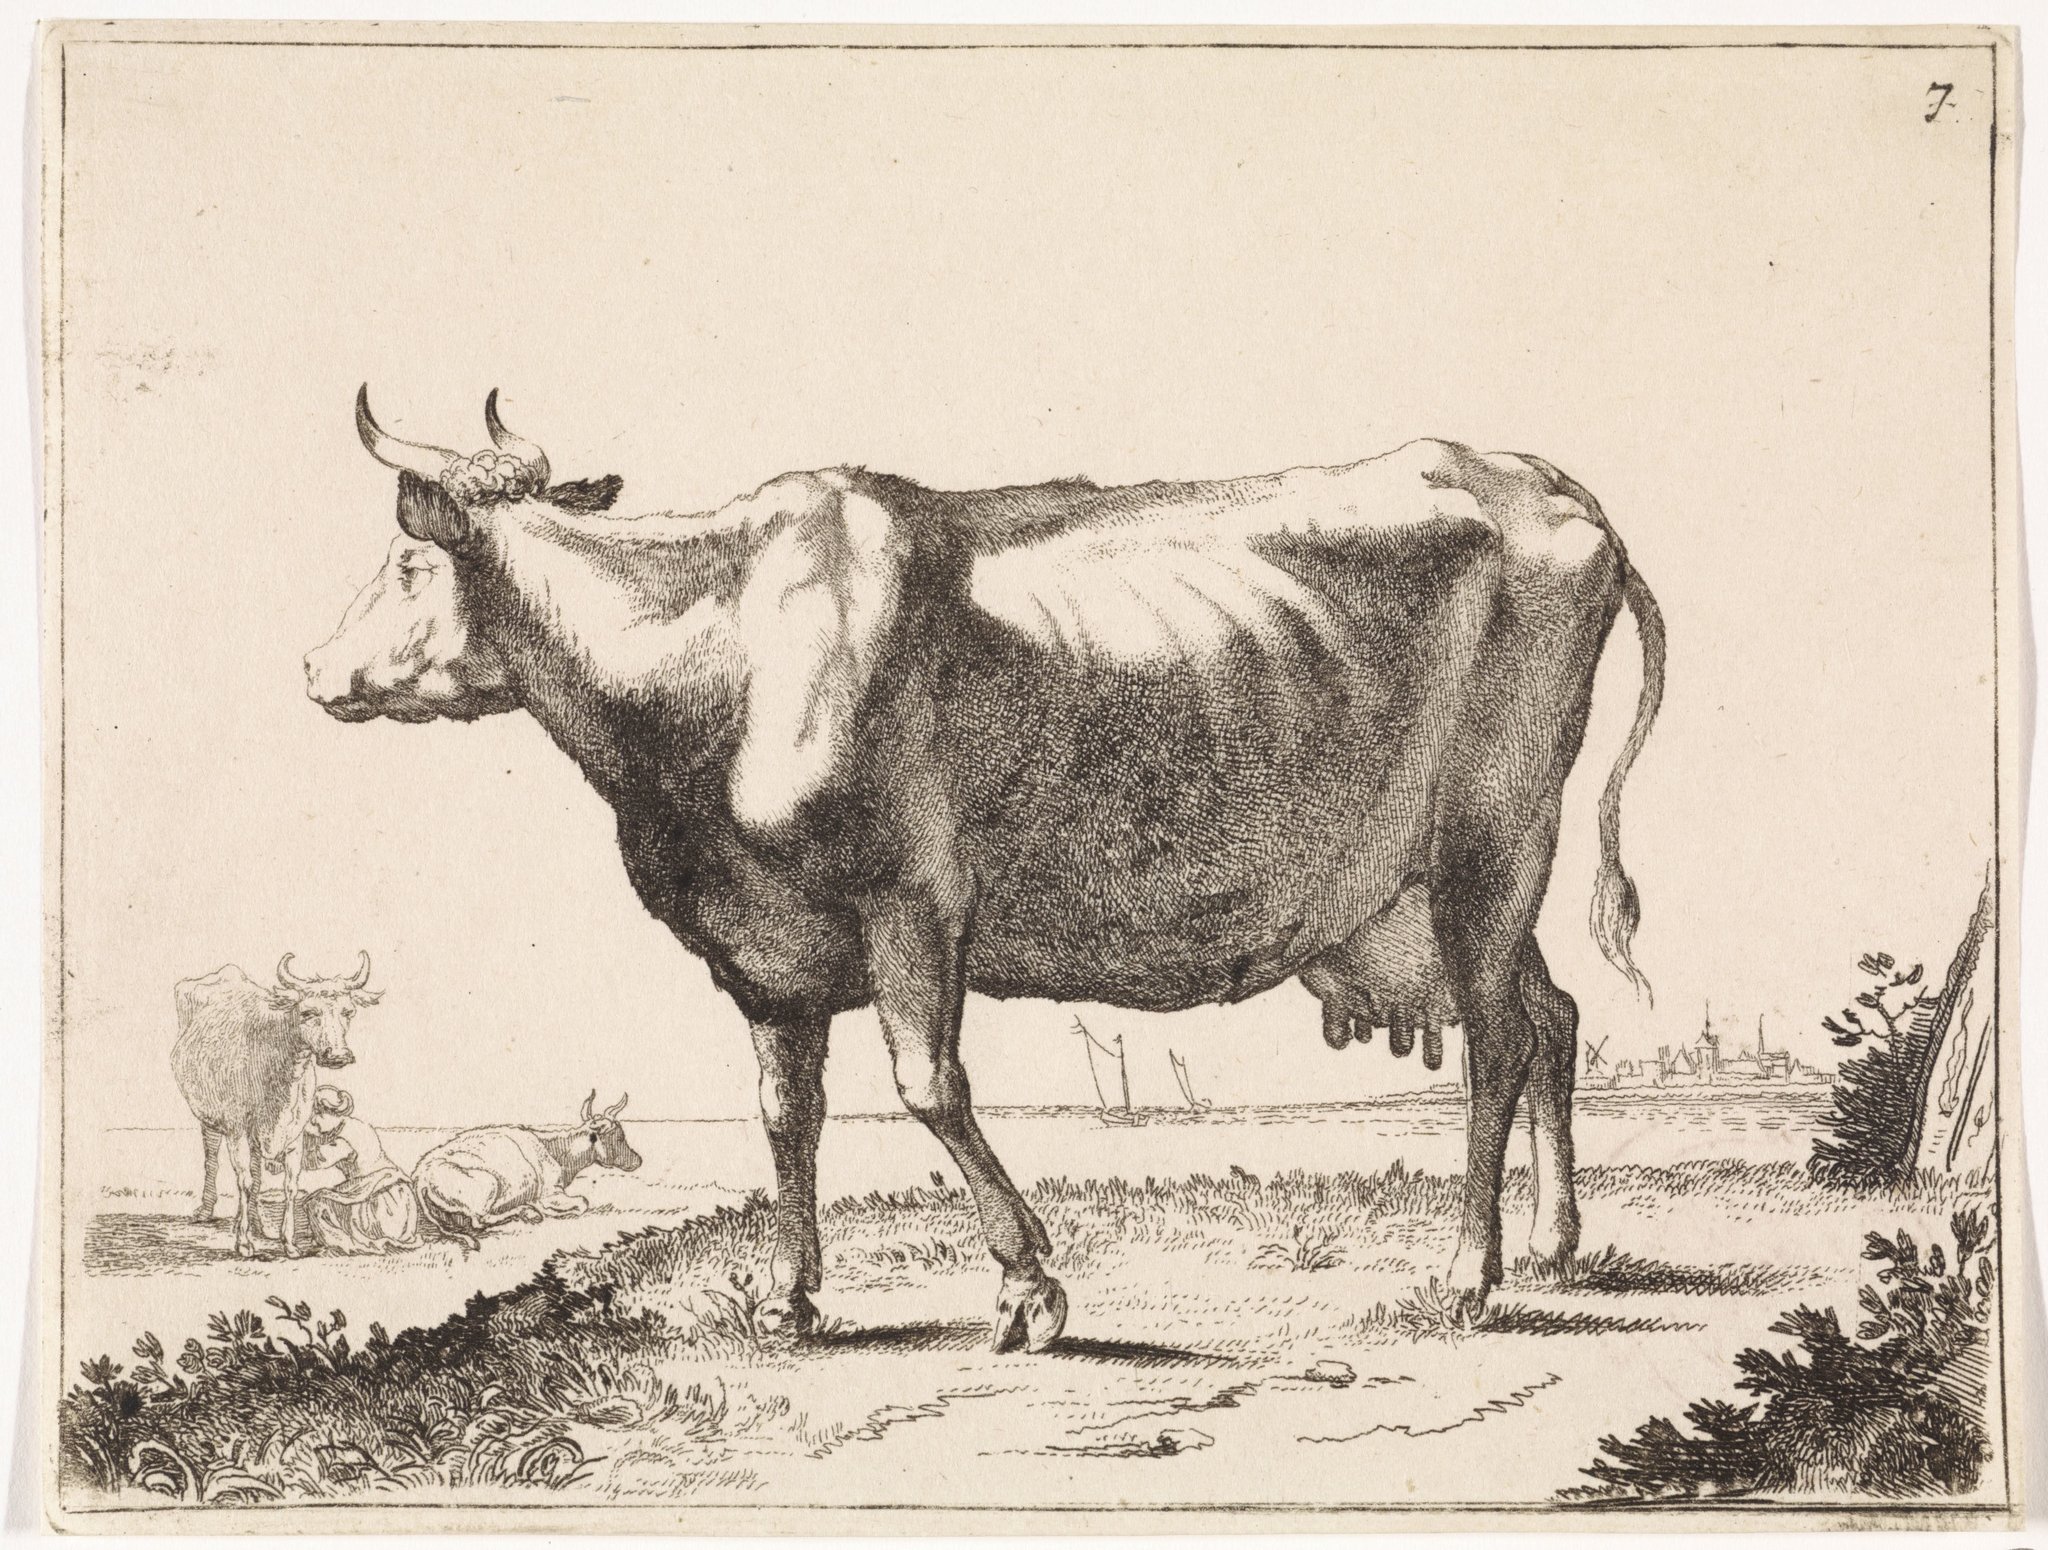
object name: print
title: Melkkoe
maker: frederik de wit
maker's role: print maker, printer, publisher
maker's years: 1629-1706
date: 1645-1706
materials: paper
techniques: etching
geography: amsterdam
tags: cow, milking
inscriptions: collector's mark: Lugt 240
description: Landschap met een melkkoe. Links op de achtergrond twee koeien, waarvan er één wordt gemolken door een meisje.